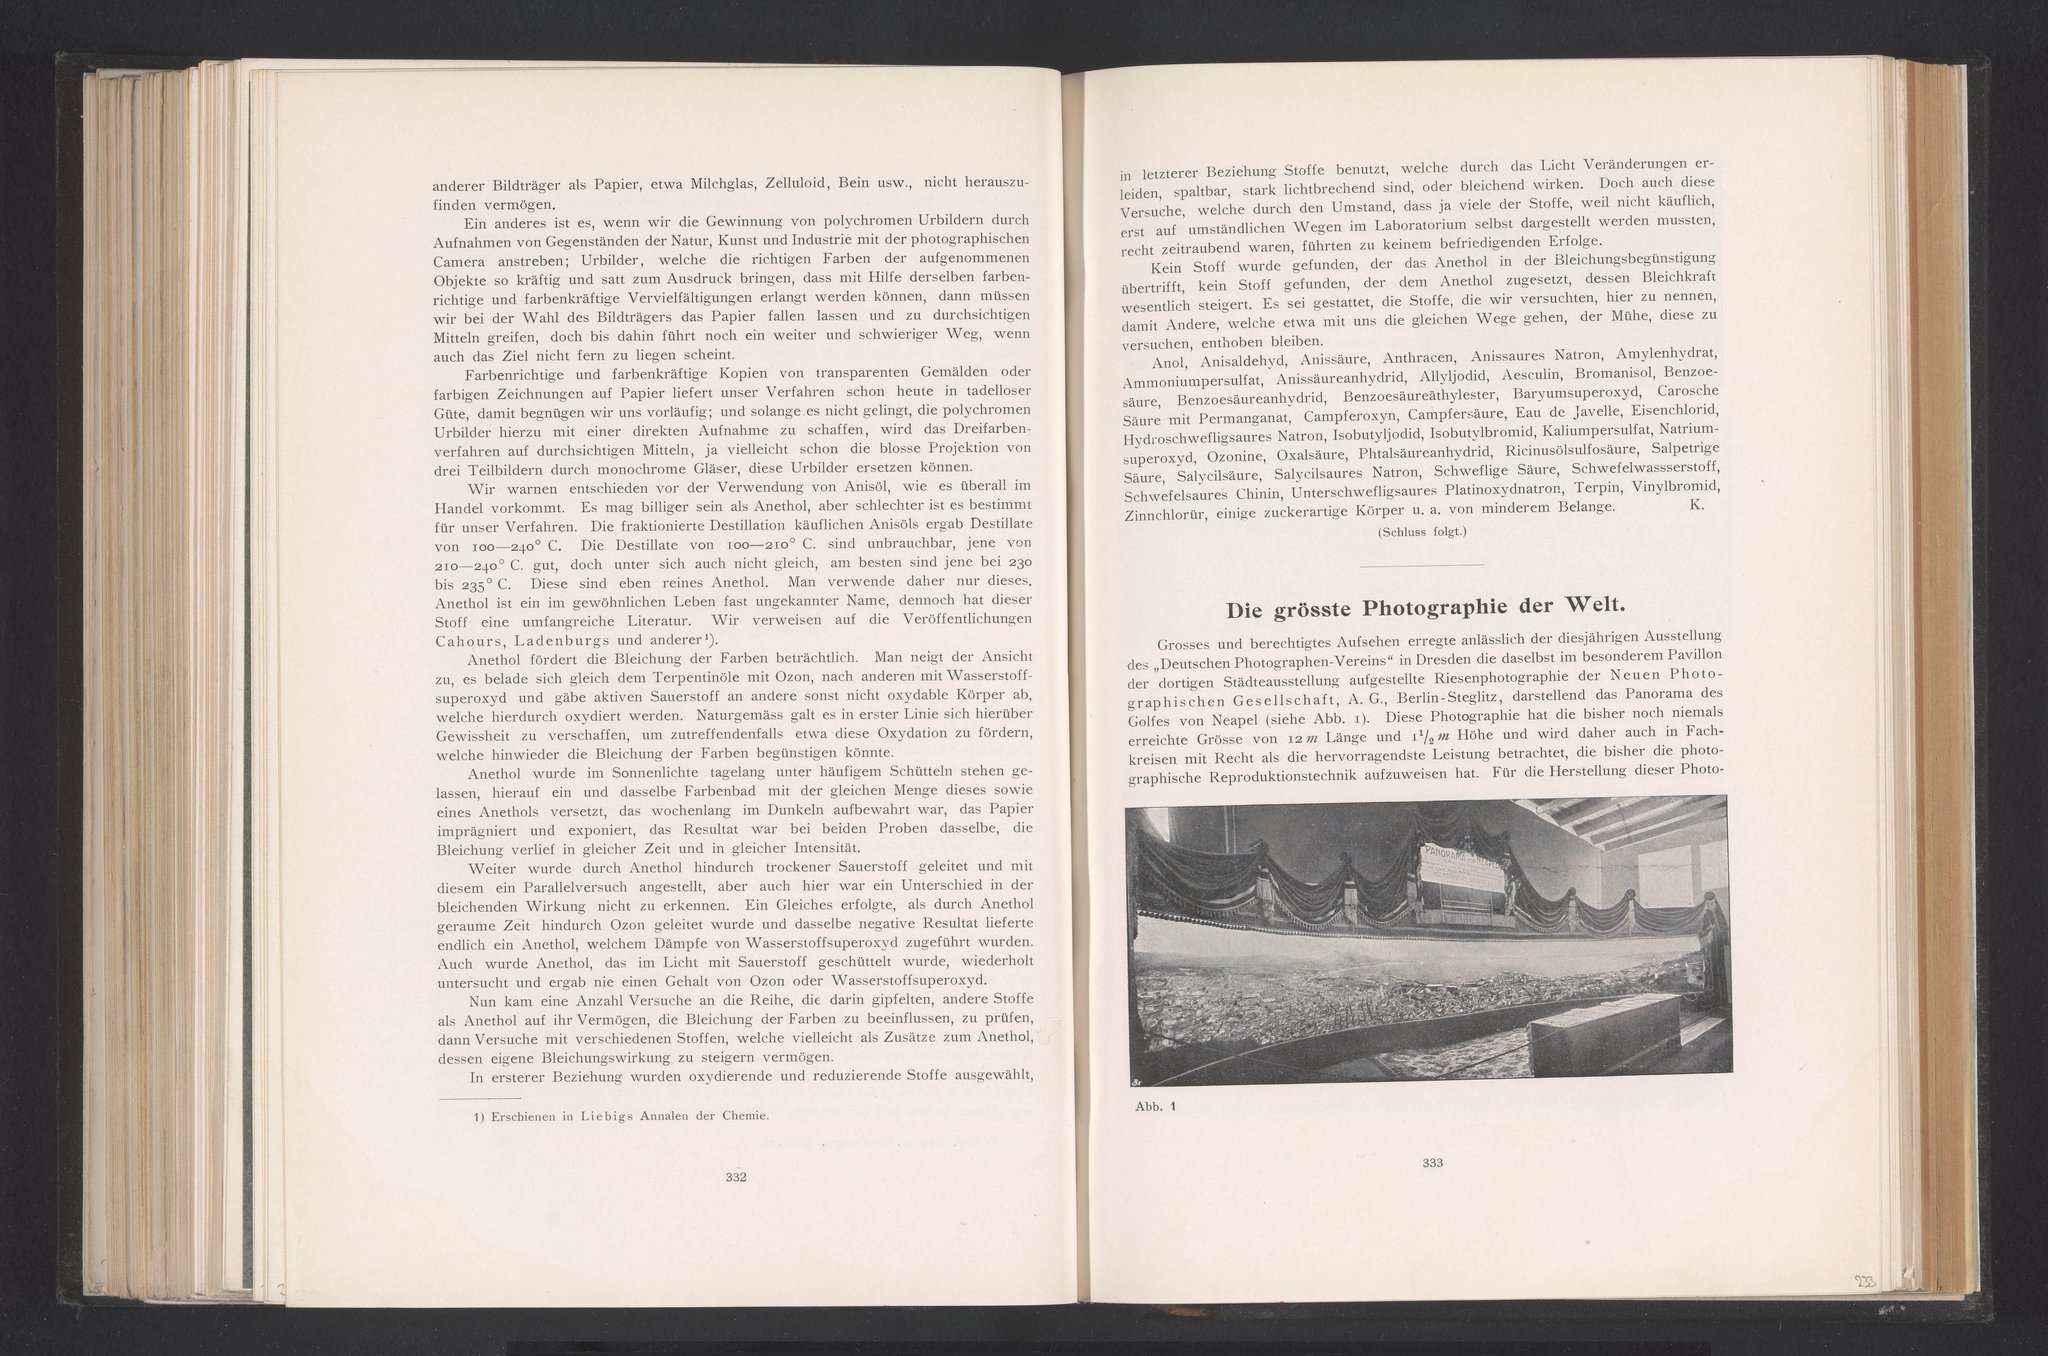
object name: page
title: Gezicht op een panoramafoto van Napels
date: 1898-1903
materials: paper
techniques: autotype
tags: prospect of city, town panorama, silhouette of city - ii - ideal city, picture within picture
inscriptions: inscription: ‘Abb. 1’, monogram: ‘BX’